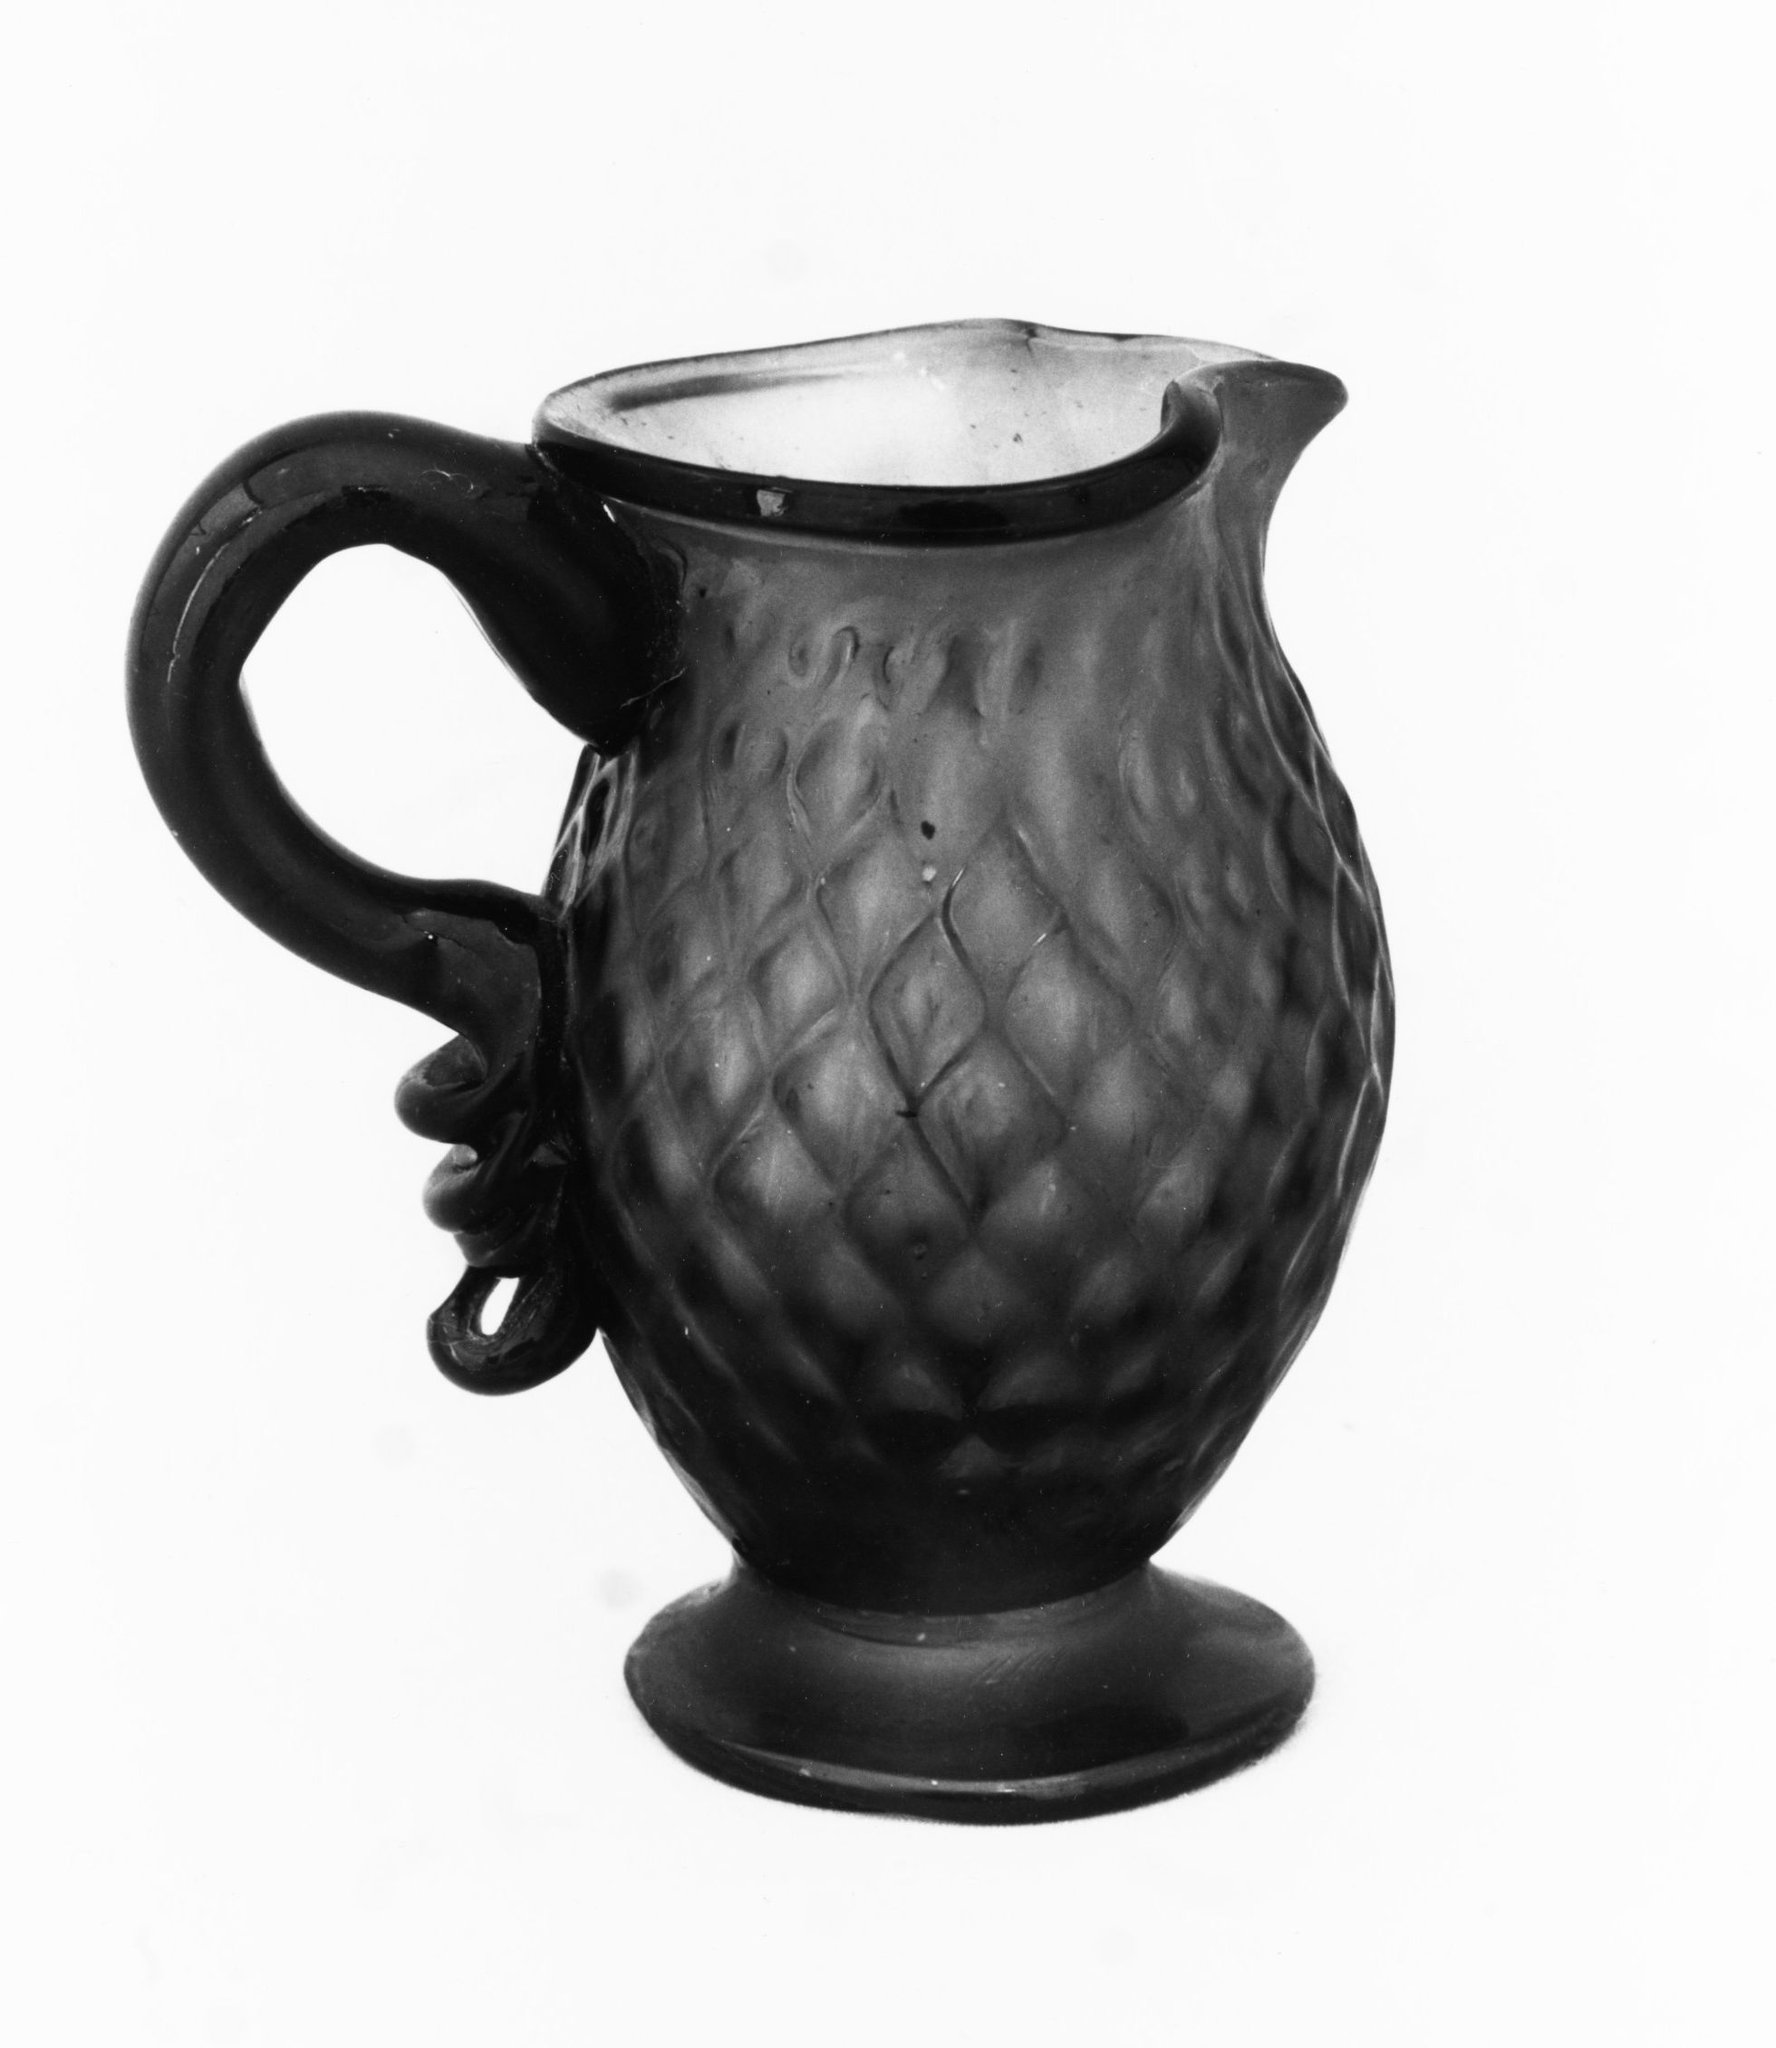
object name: cream pot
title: Creamer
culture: american or british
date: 1780-1820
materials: glass, lead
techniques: glassblowing, molding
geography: england